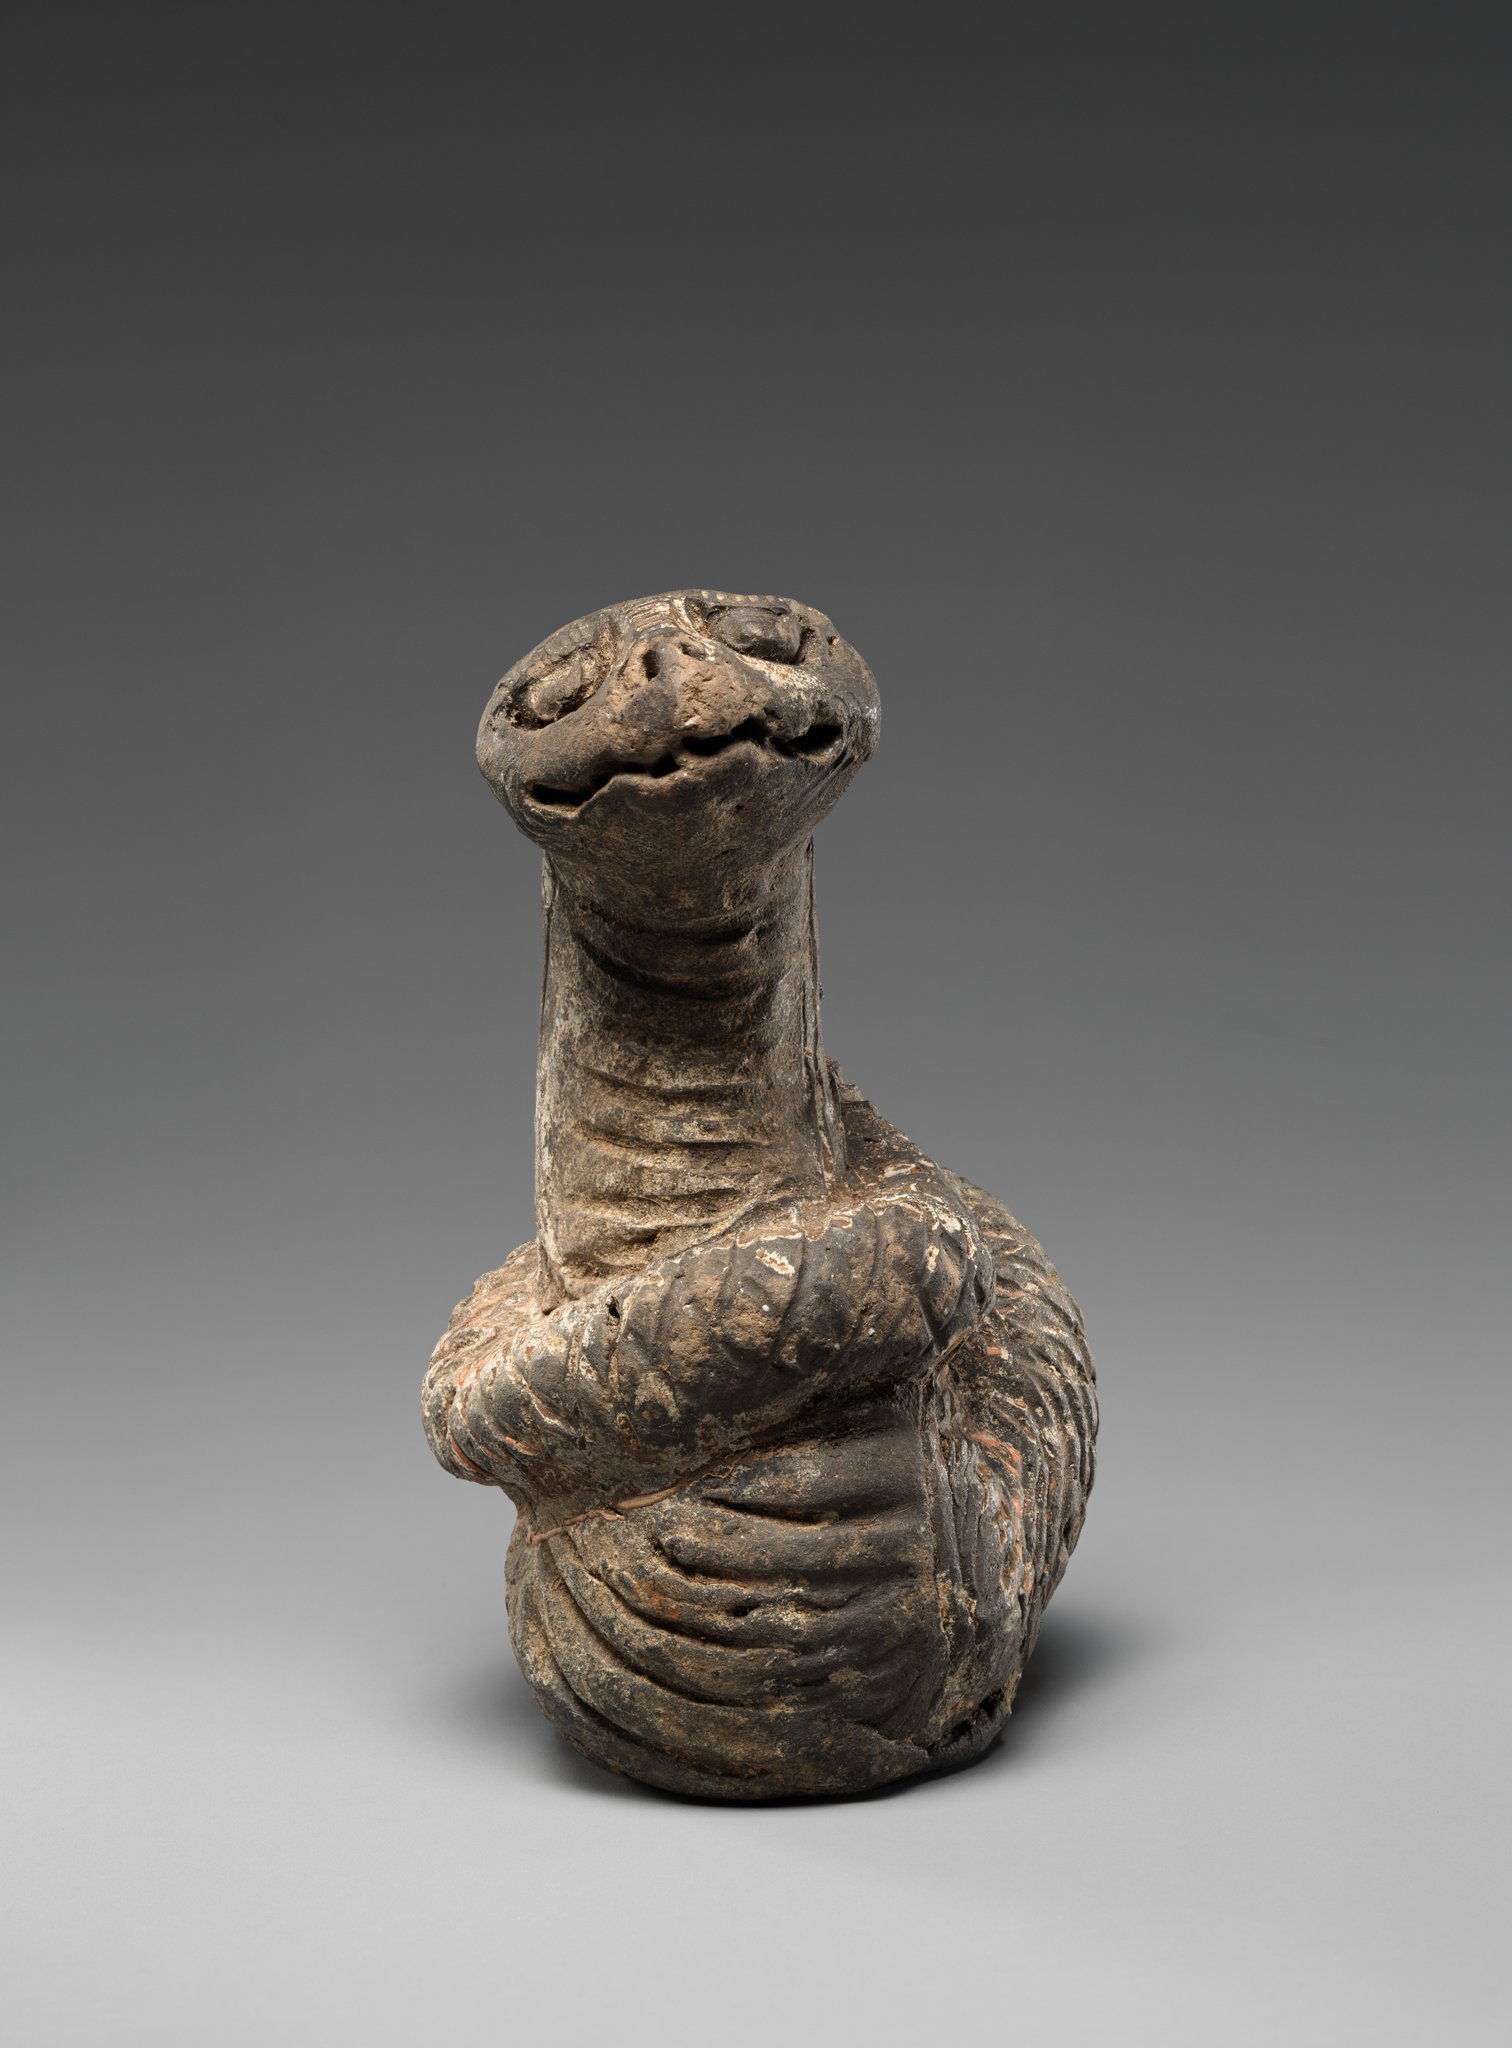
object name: figure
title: Chinese zodiac figure, snake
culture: chinese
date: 1201-1300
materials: earthenware, pigment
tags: serpents